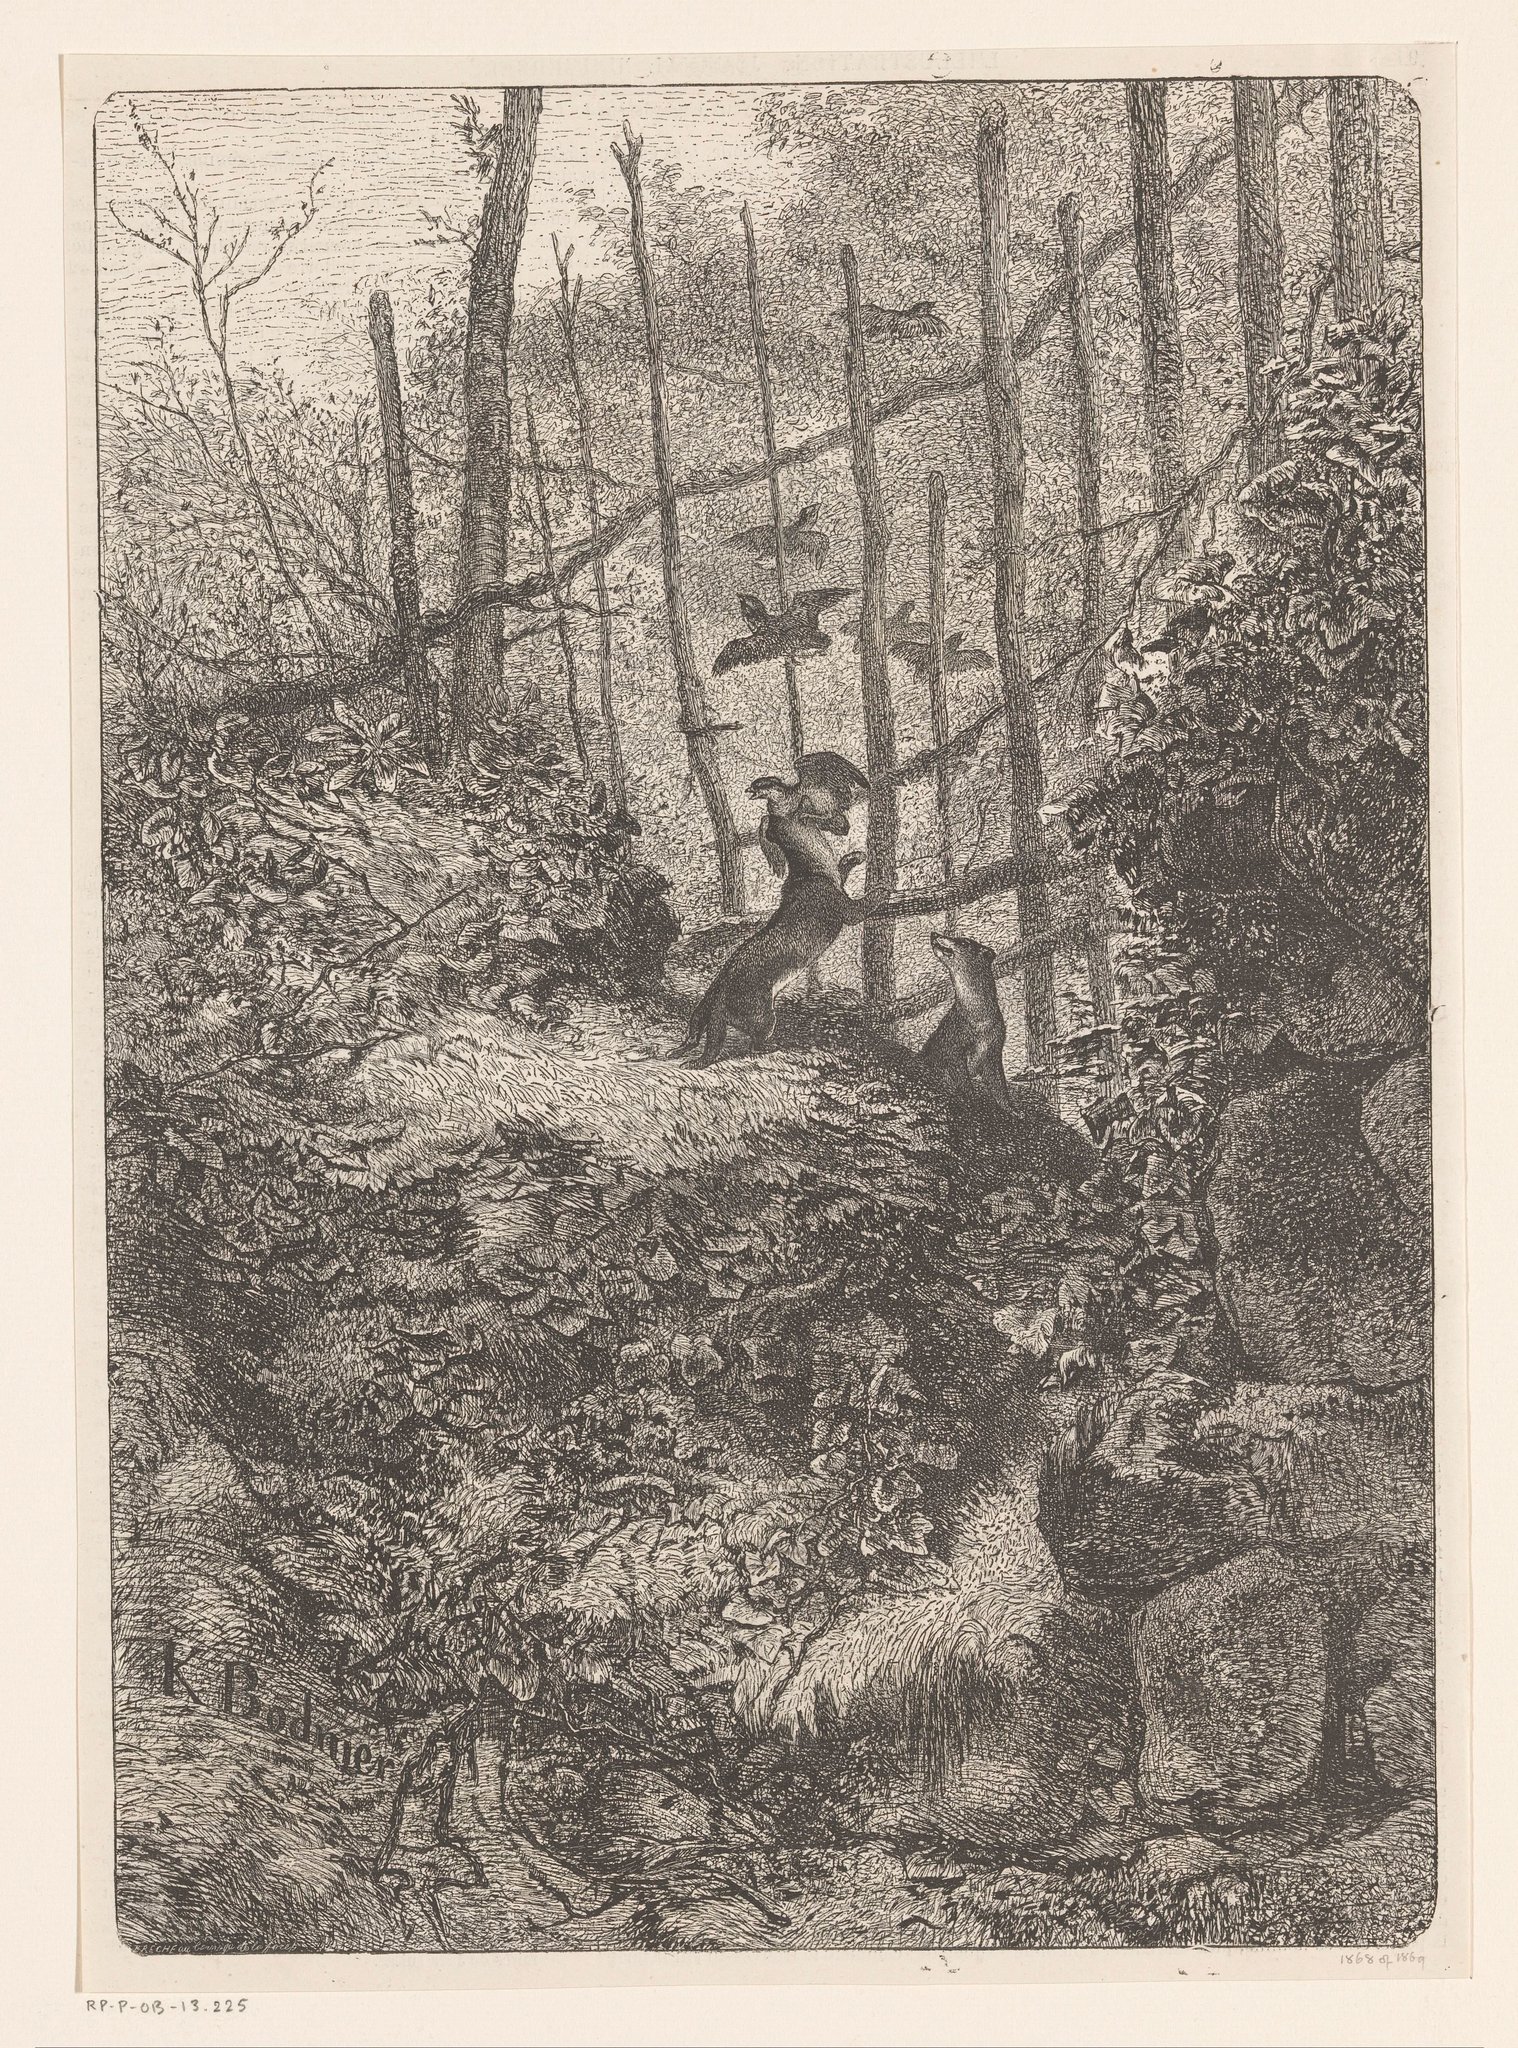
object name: illustration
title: Fretten vangen vogels in een bos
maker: karl bodmer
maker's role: draughtsman, painter, print maker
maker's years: 1809-1893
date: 1867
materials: paper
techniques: lithography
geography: barbizon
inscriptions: collector's mark: Lugt 2228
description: Prent afkomstig uit: L'illustration 50 (1867), p. 93